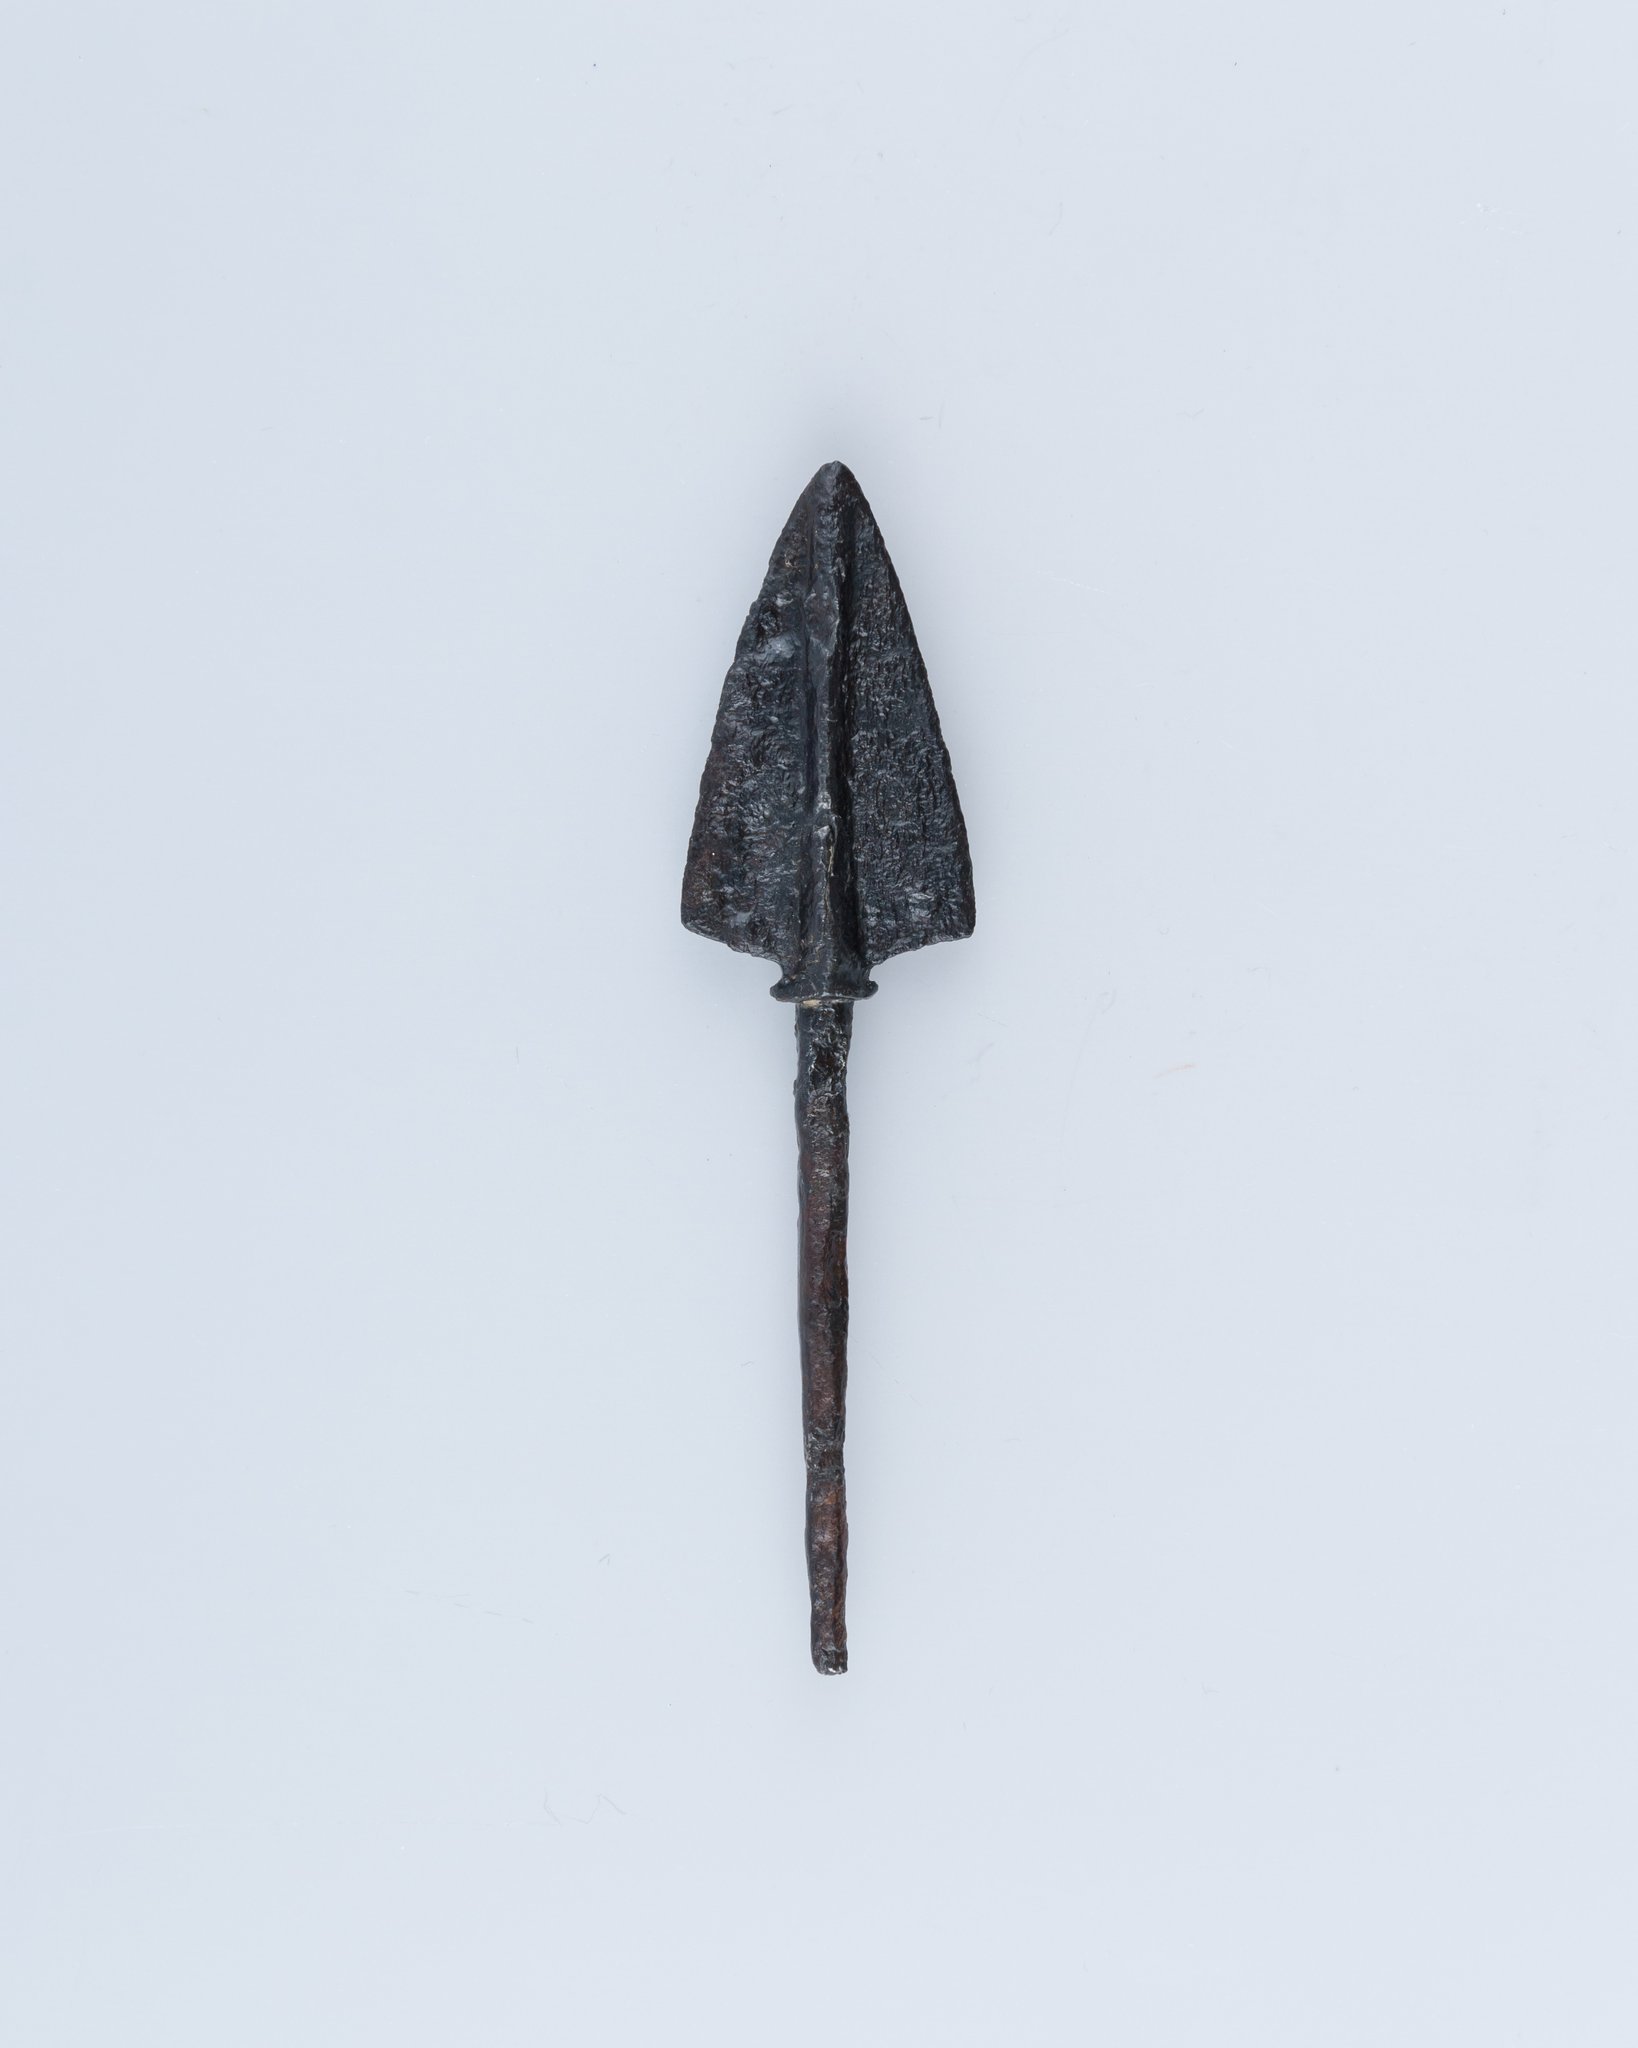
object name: arrowhead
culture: tibetan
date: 1401-1700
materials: iron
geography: tibet